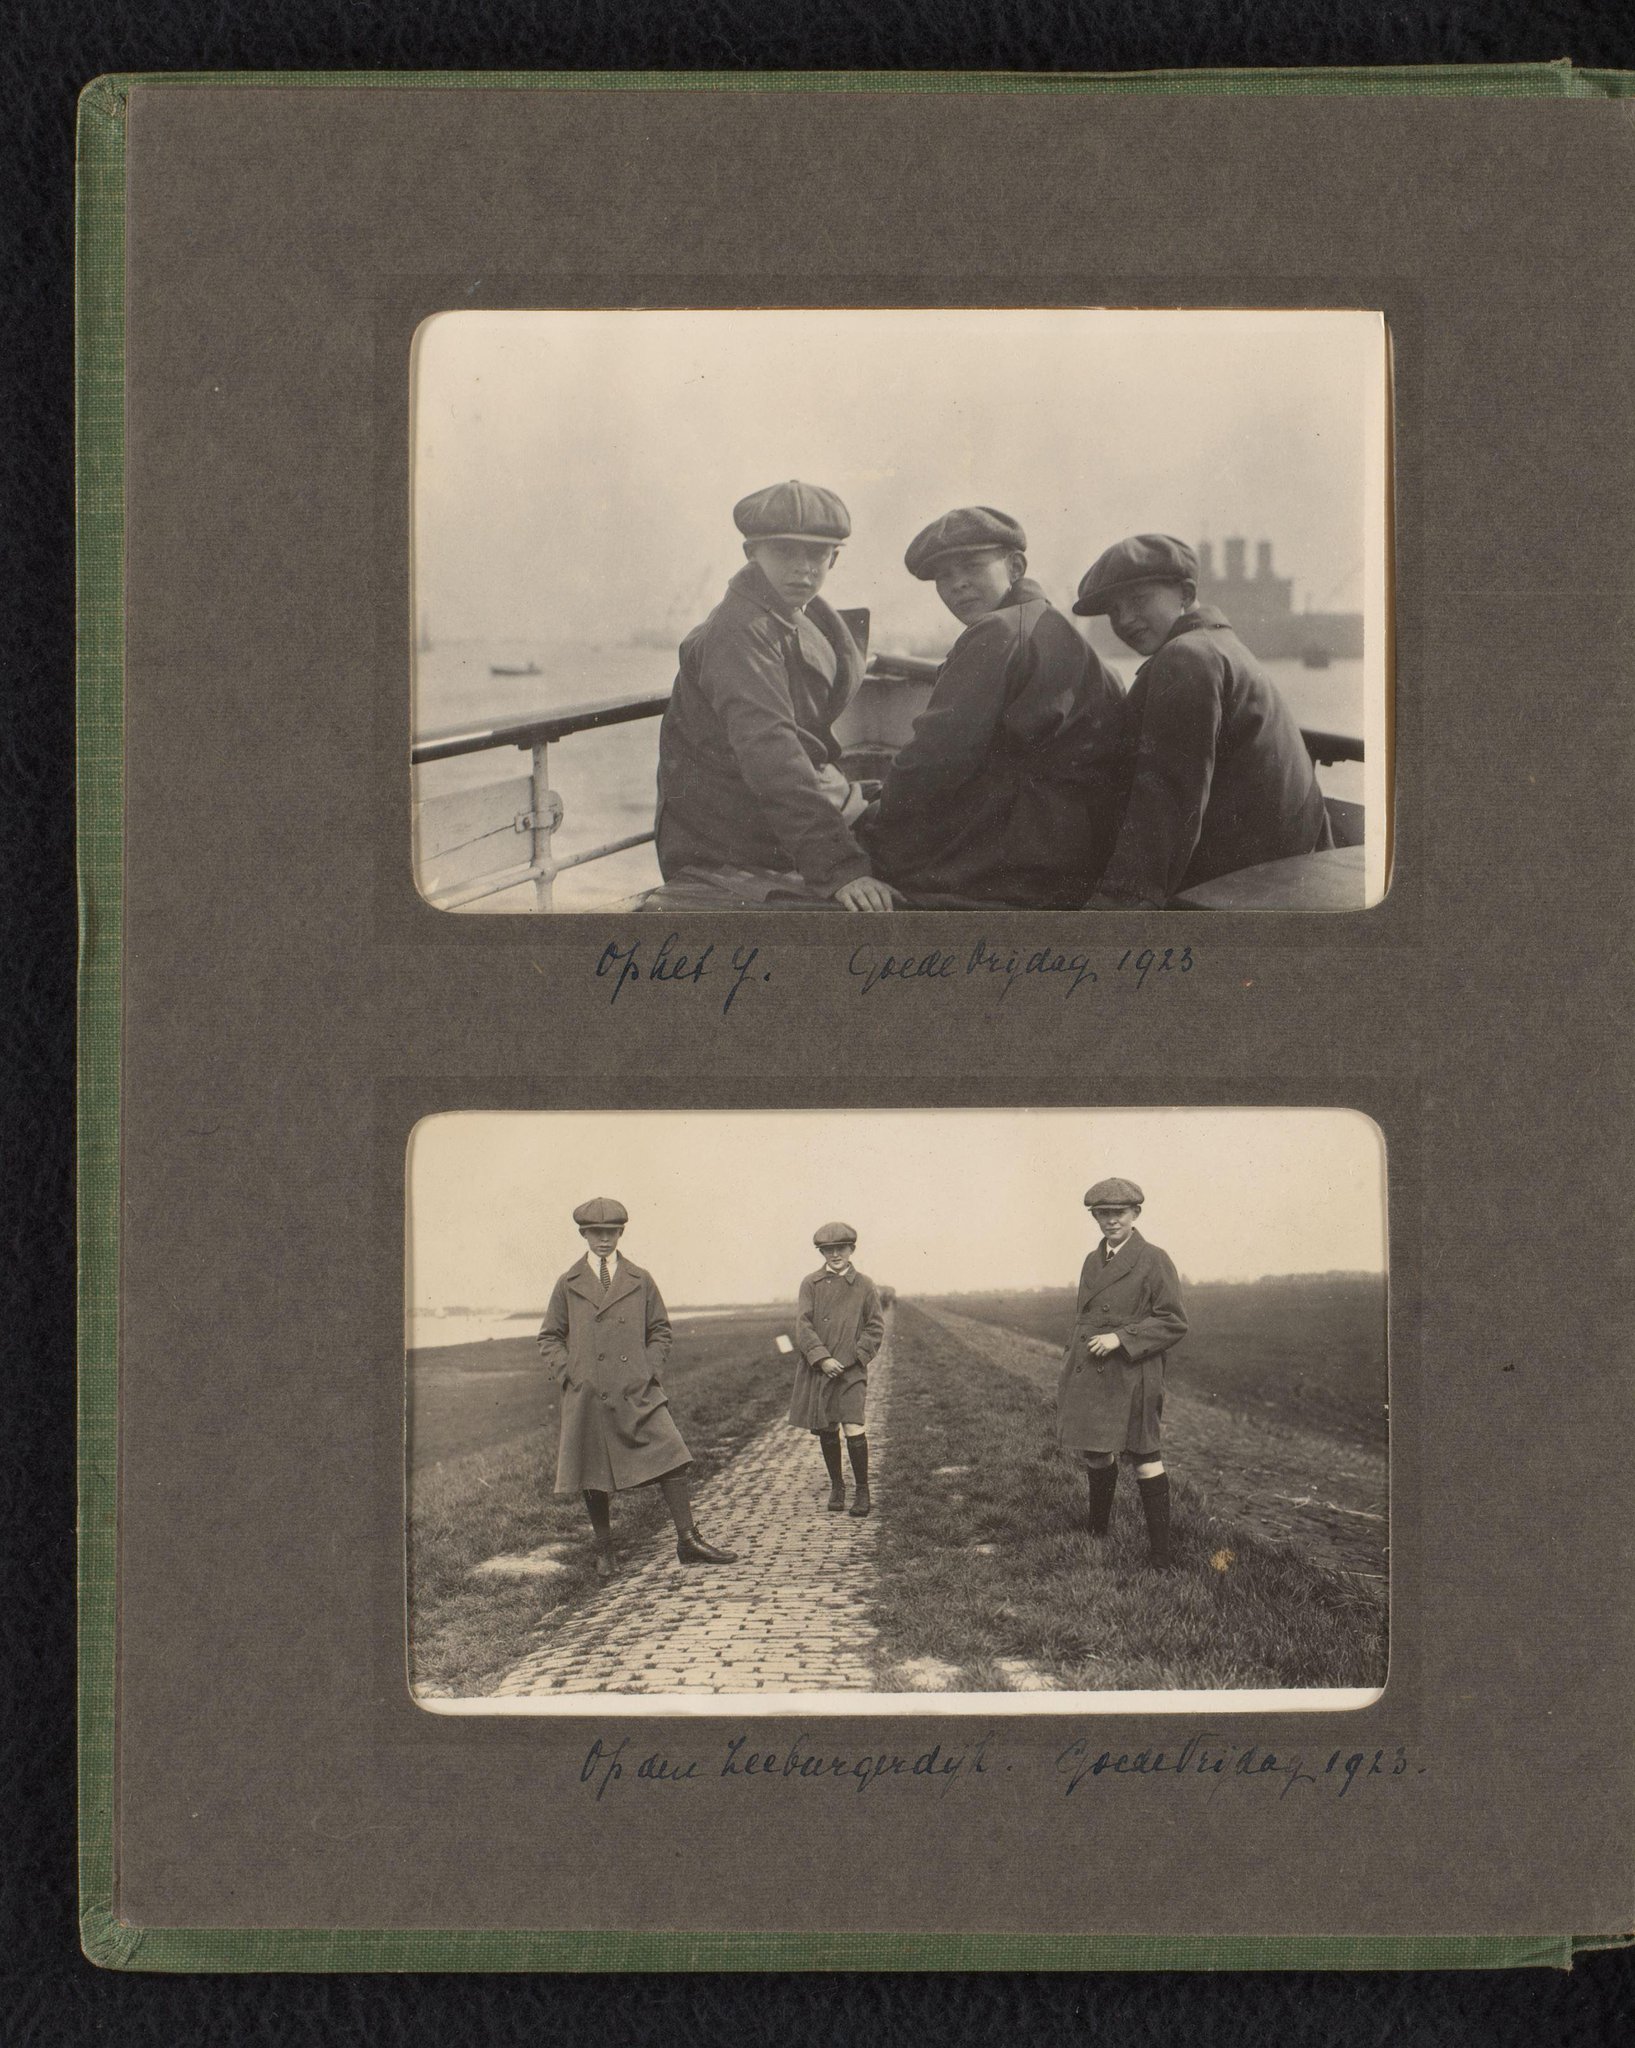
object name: album leaf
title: Twee foto's van drie kinderen op het IJ en op de Zeeburgerdijk, 1923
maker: hendrik herman van den berg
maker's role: amateurfotograaf, jurist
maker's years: 1875-1944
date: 1923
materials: paper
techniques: gelatin silver print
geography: north holland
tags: boy (child between toddler and youth)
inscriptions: inscription: ‘Op den Zeeburgerdijk. Goede Vrijdag 1923.’, inscription: ‘Op het IJ. Goede Vrijdag, 1923’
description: Deze foto's maken deel uit van een album.